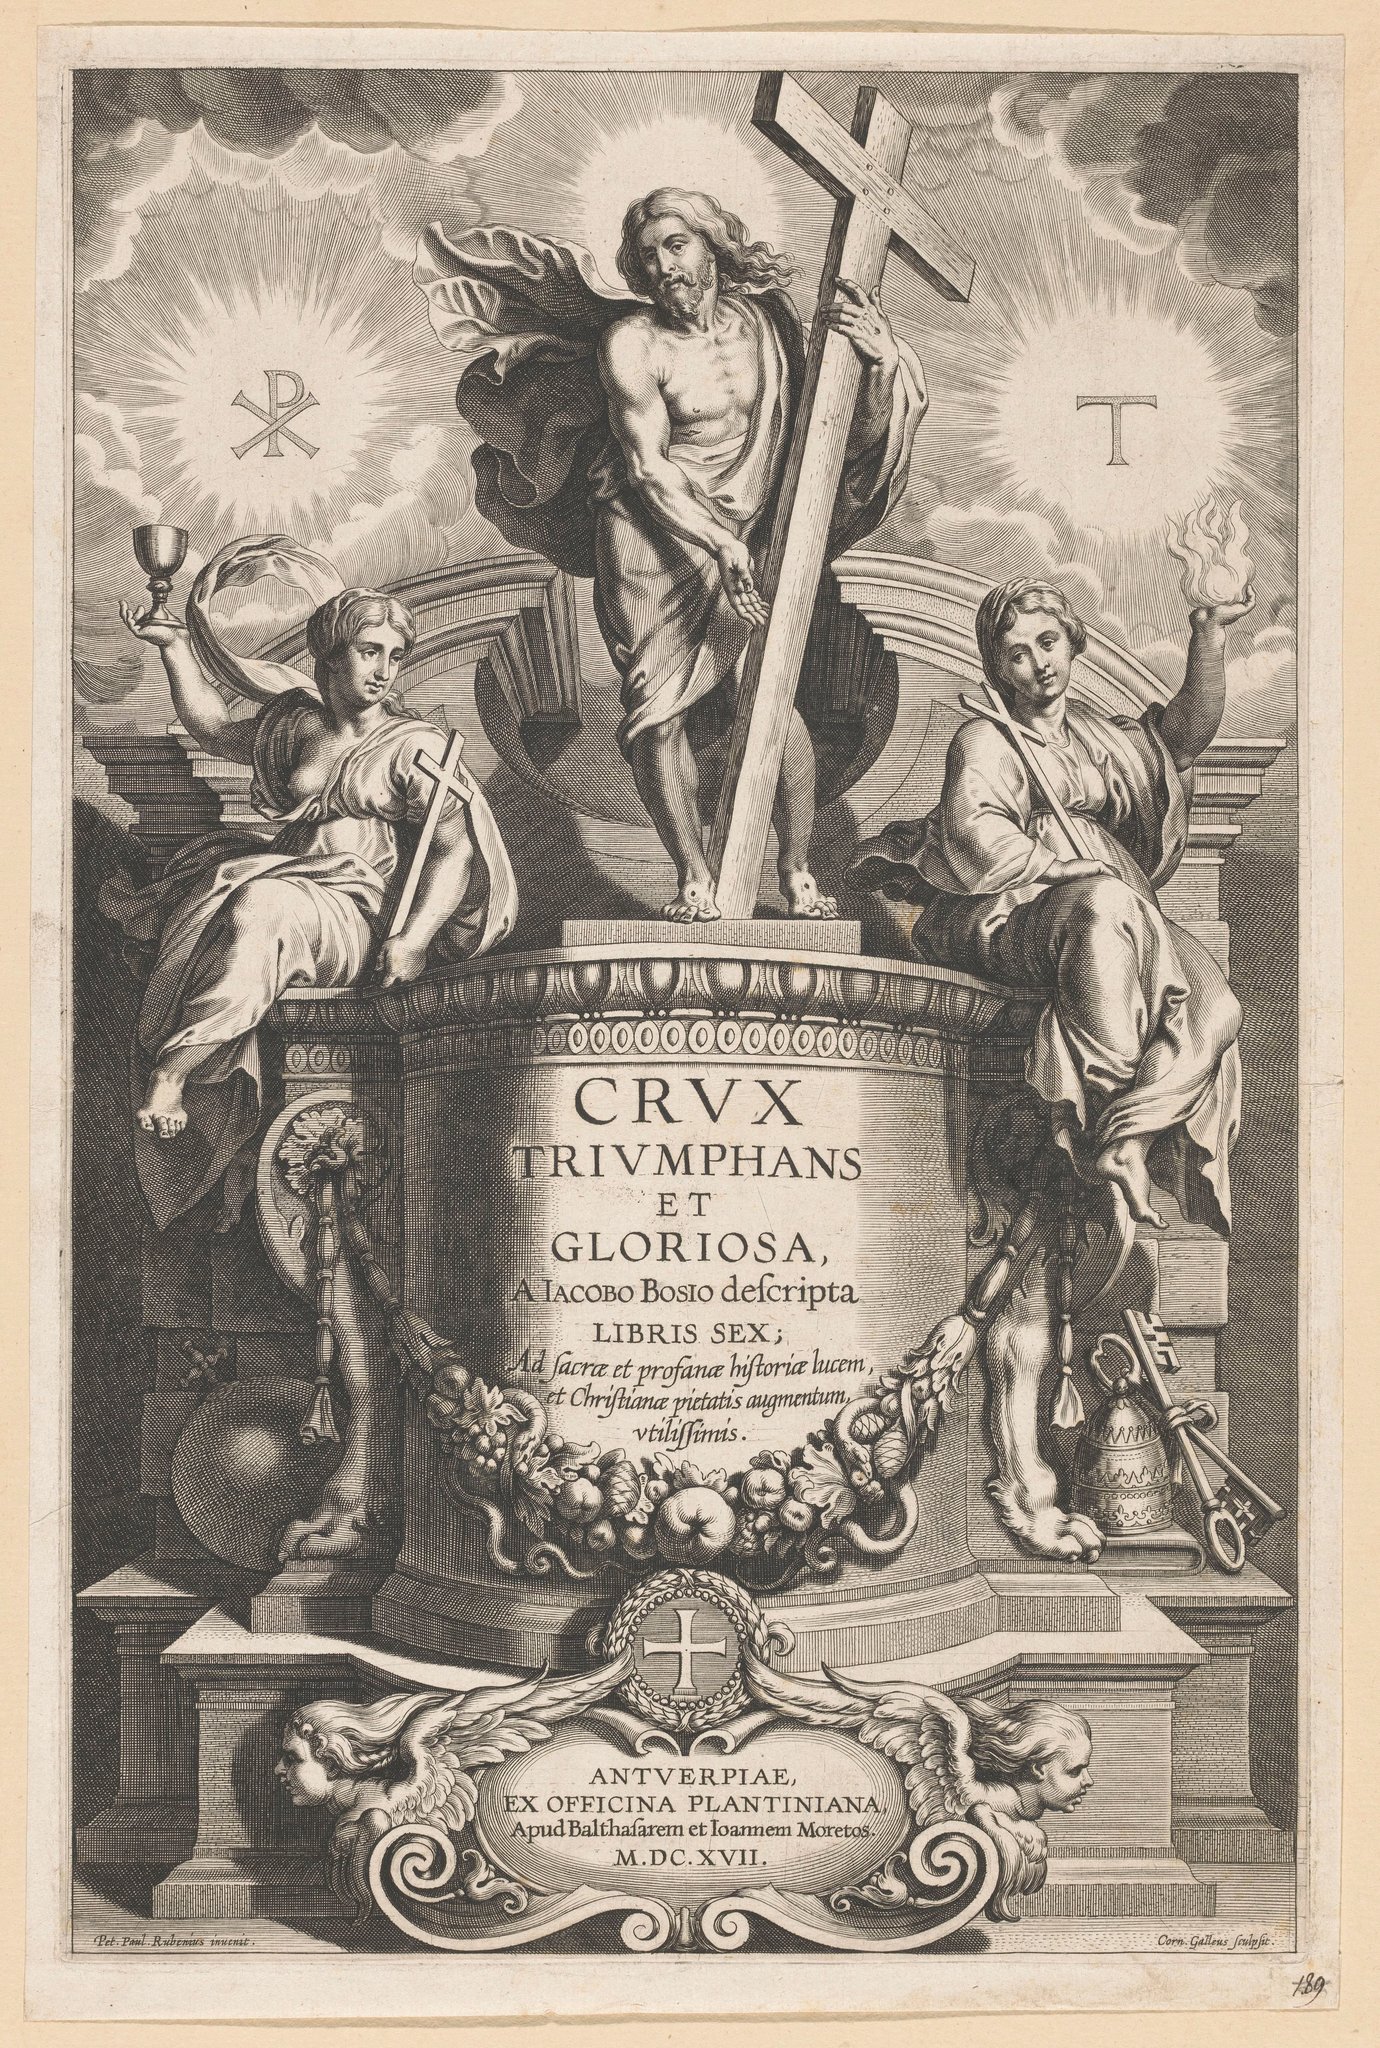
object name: titelblad, titelpagina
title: Christus, Geloof en Liefde zittend op een graftombe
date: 1617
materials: paper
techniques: engraving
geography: antwerp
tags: specific forms of the cross: greek cross, faith, 'fides'; 'fede', 'fede catholica', 'fede christiana', 'fede christiana catholica' (ripa) ~ one of the three theological virtues, hope, 'spes'; 'speranza divina e certa' (ripa) ~ one of the three theological virtues, the cross ~ symbols of christ, letters and monograms ~ symbols of christ, specific forms of the cross: tau-cross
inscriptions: collector's mark: Lugt 240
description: Christus met het kruis in zijn handen staat op een graftombe. Aan weerszijden zitten de personificaties van Geloof, met kelk en kruis, en Liefde, met vlam en kruis. Verschillende types van het kruis zijn in de compositie verwerkt, onder het Griekse kruis, links het Christusmonogram en rechts het taukruis.